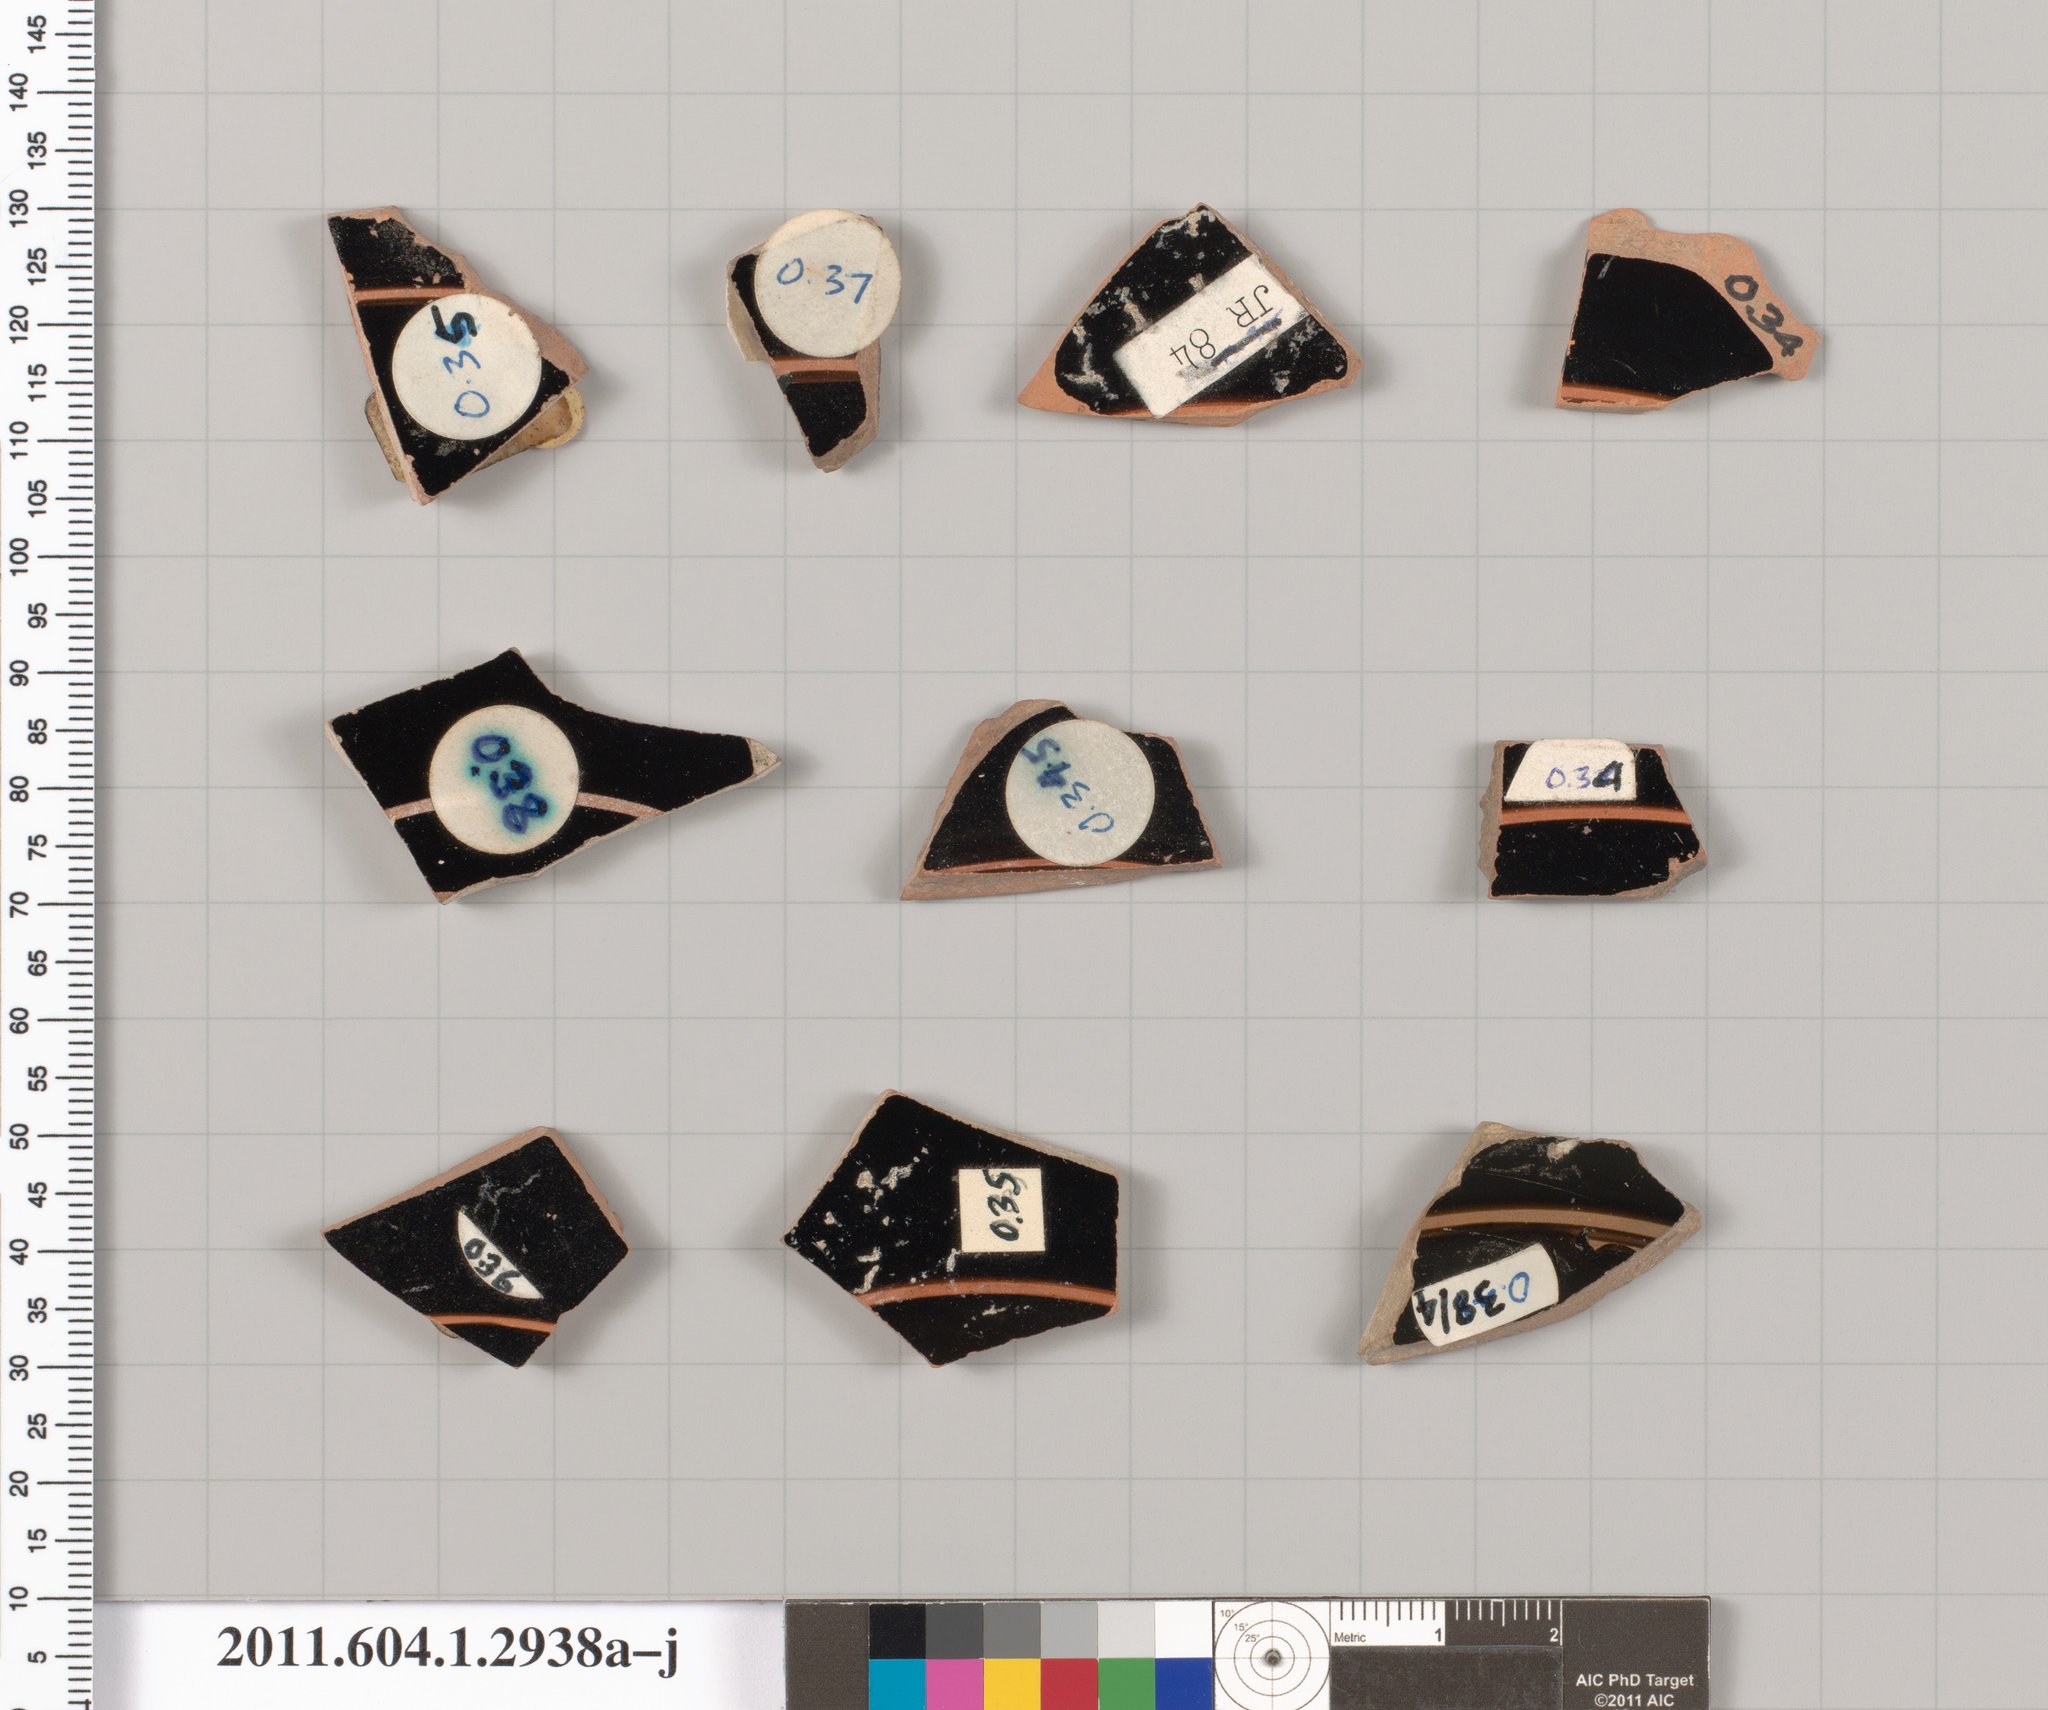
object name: kylix fragment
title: Terracotta fragments of kylikes (drinking cups)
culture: greek, attic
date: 500-476 BCE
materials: terracotta